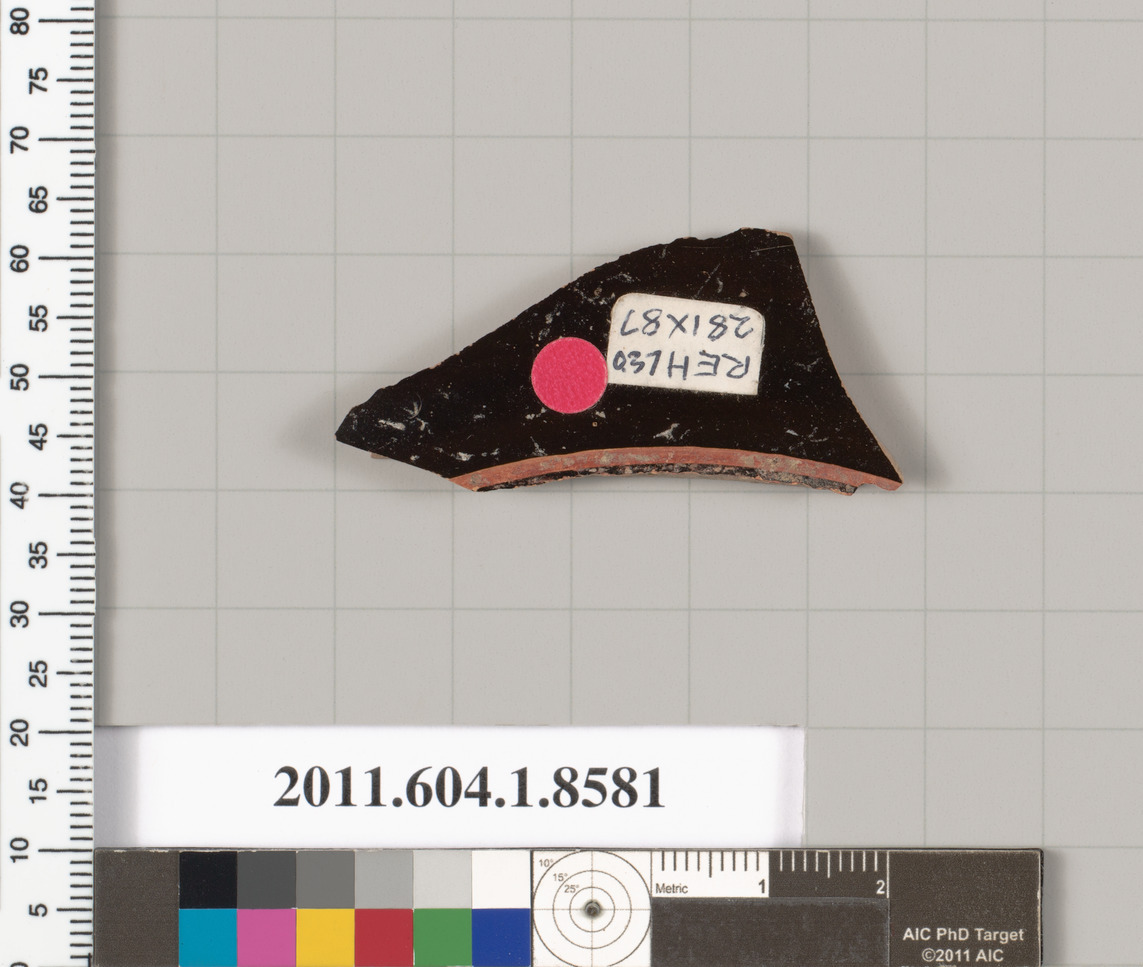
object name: kylix fragment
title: Terracotta fragment of a stemless kylix (drinking cup)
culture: greek, attic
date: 475-451 BCE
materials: terracotta